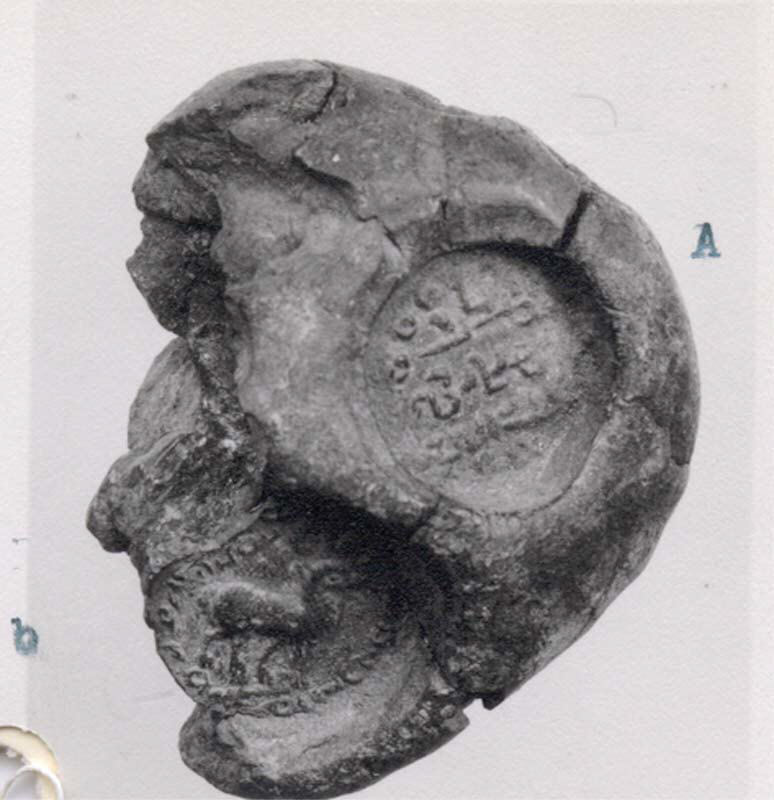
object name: sealing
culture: sasanian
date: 601-700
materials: clay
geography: iran